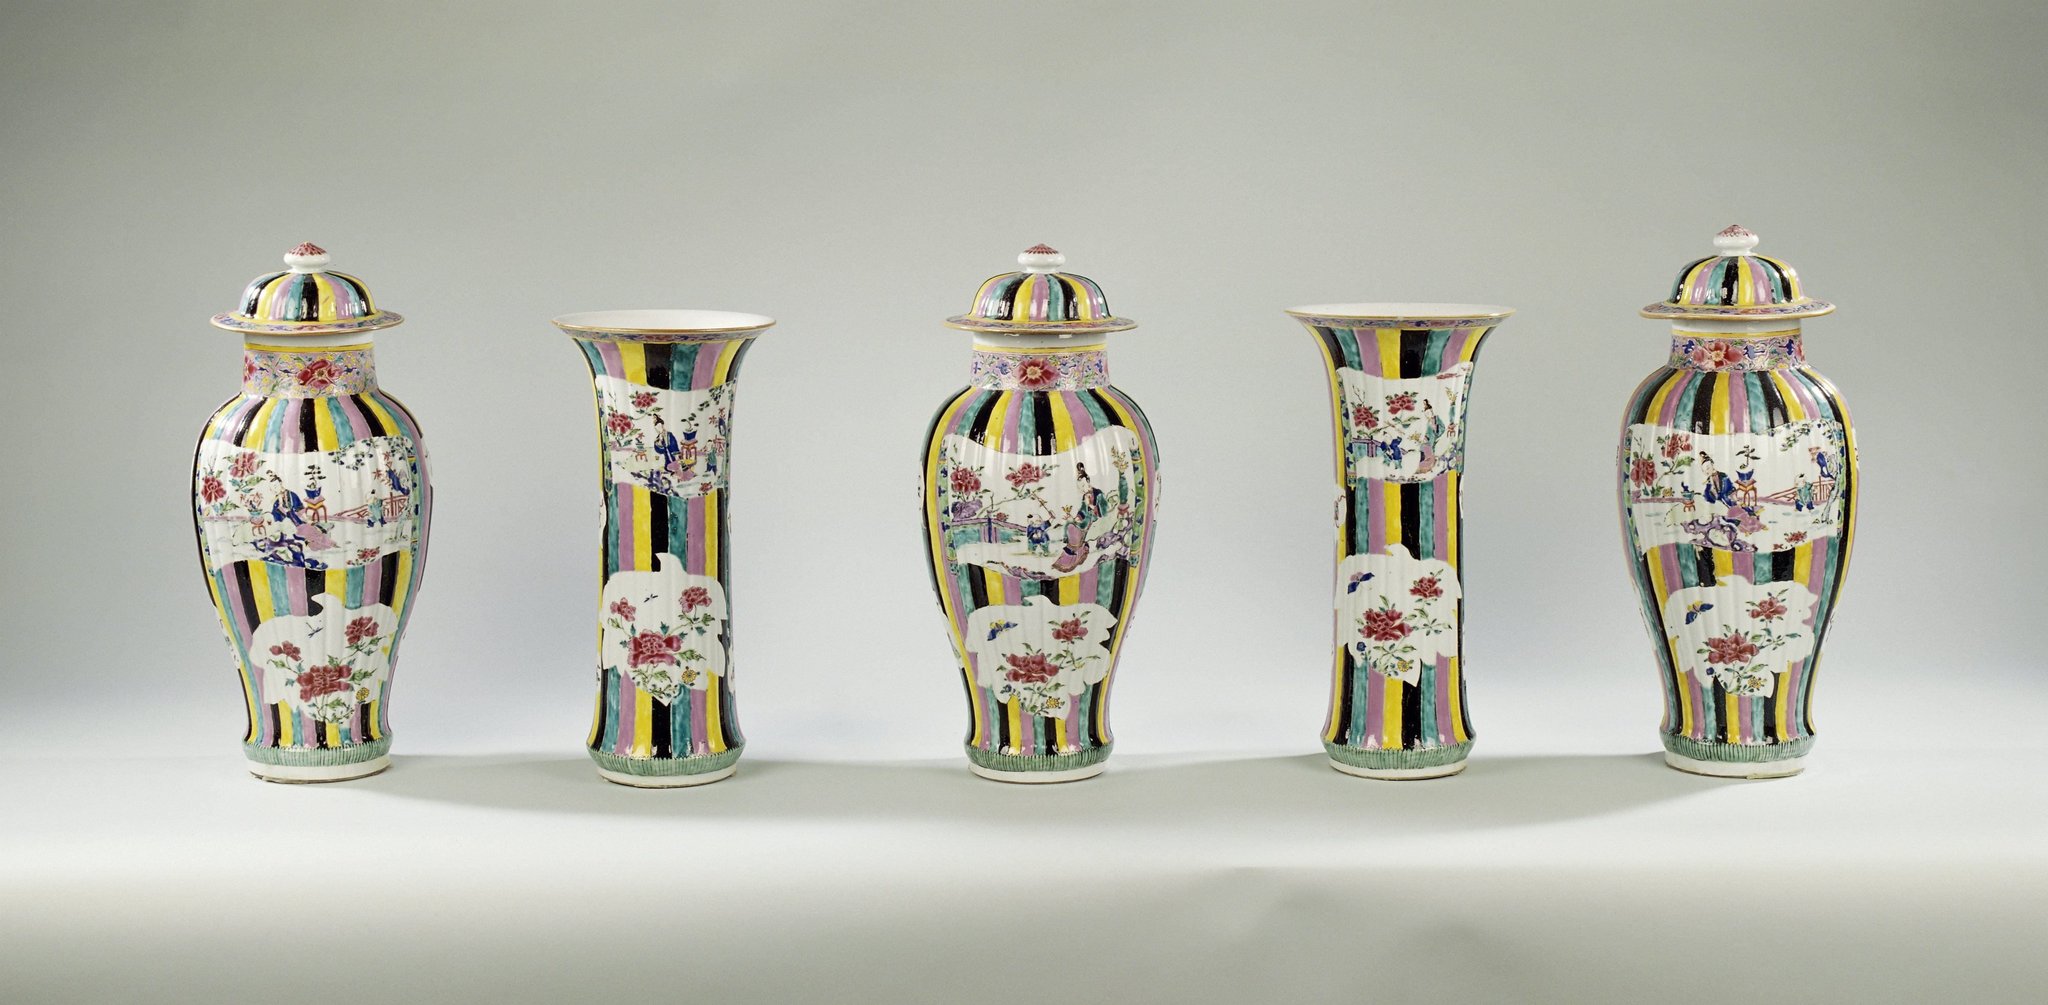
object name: kaststel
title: Garniture with figures, flower sprays and auspicious symbols in shaped panels on a multi-colored ground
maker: Anonymous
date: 1725-1740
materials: glaze, gold, paint, porcelain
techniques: firing, forming, gilding, turning, vitrification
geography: china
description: Kaststel, bestaande uit vijf vazen waarvan drie met deksels, famille rose, zgn. "harlequin" motief. Het fond bestaat uit verticale banden in zwart, geel, violet en turquoise.